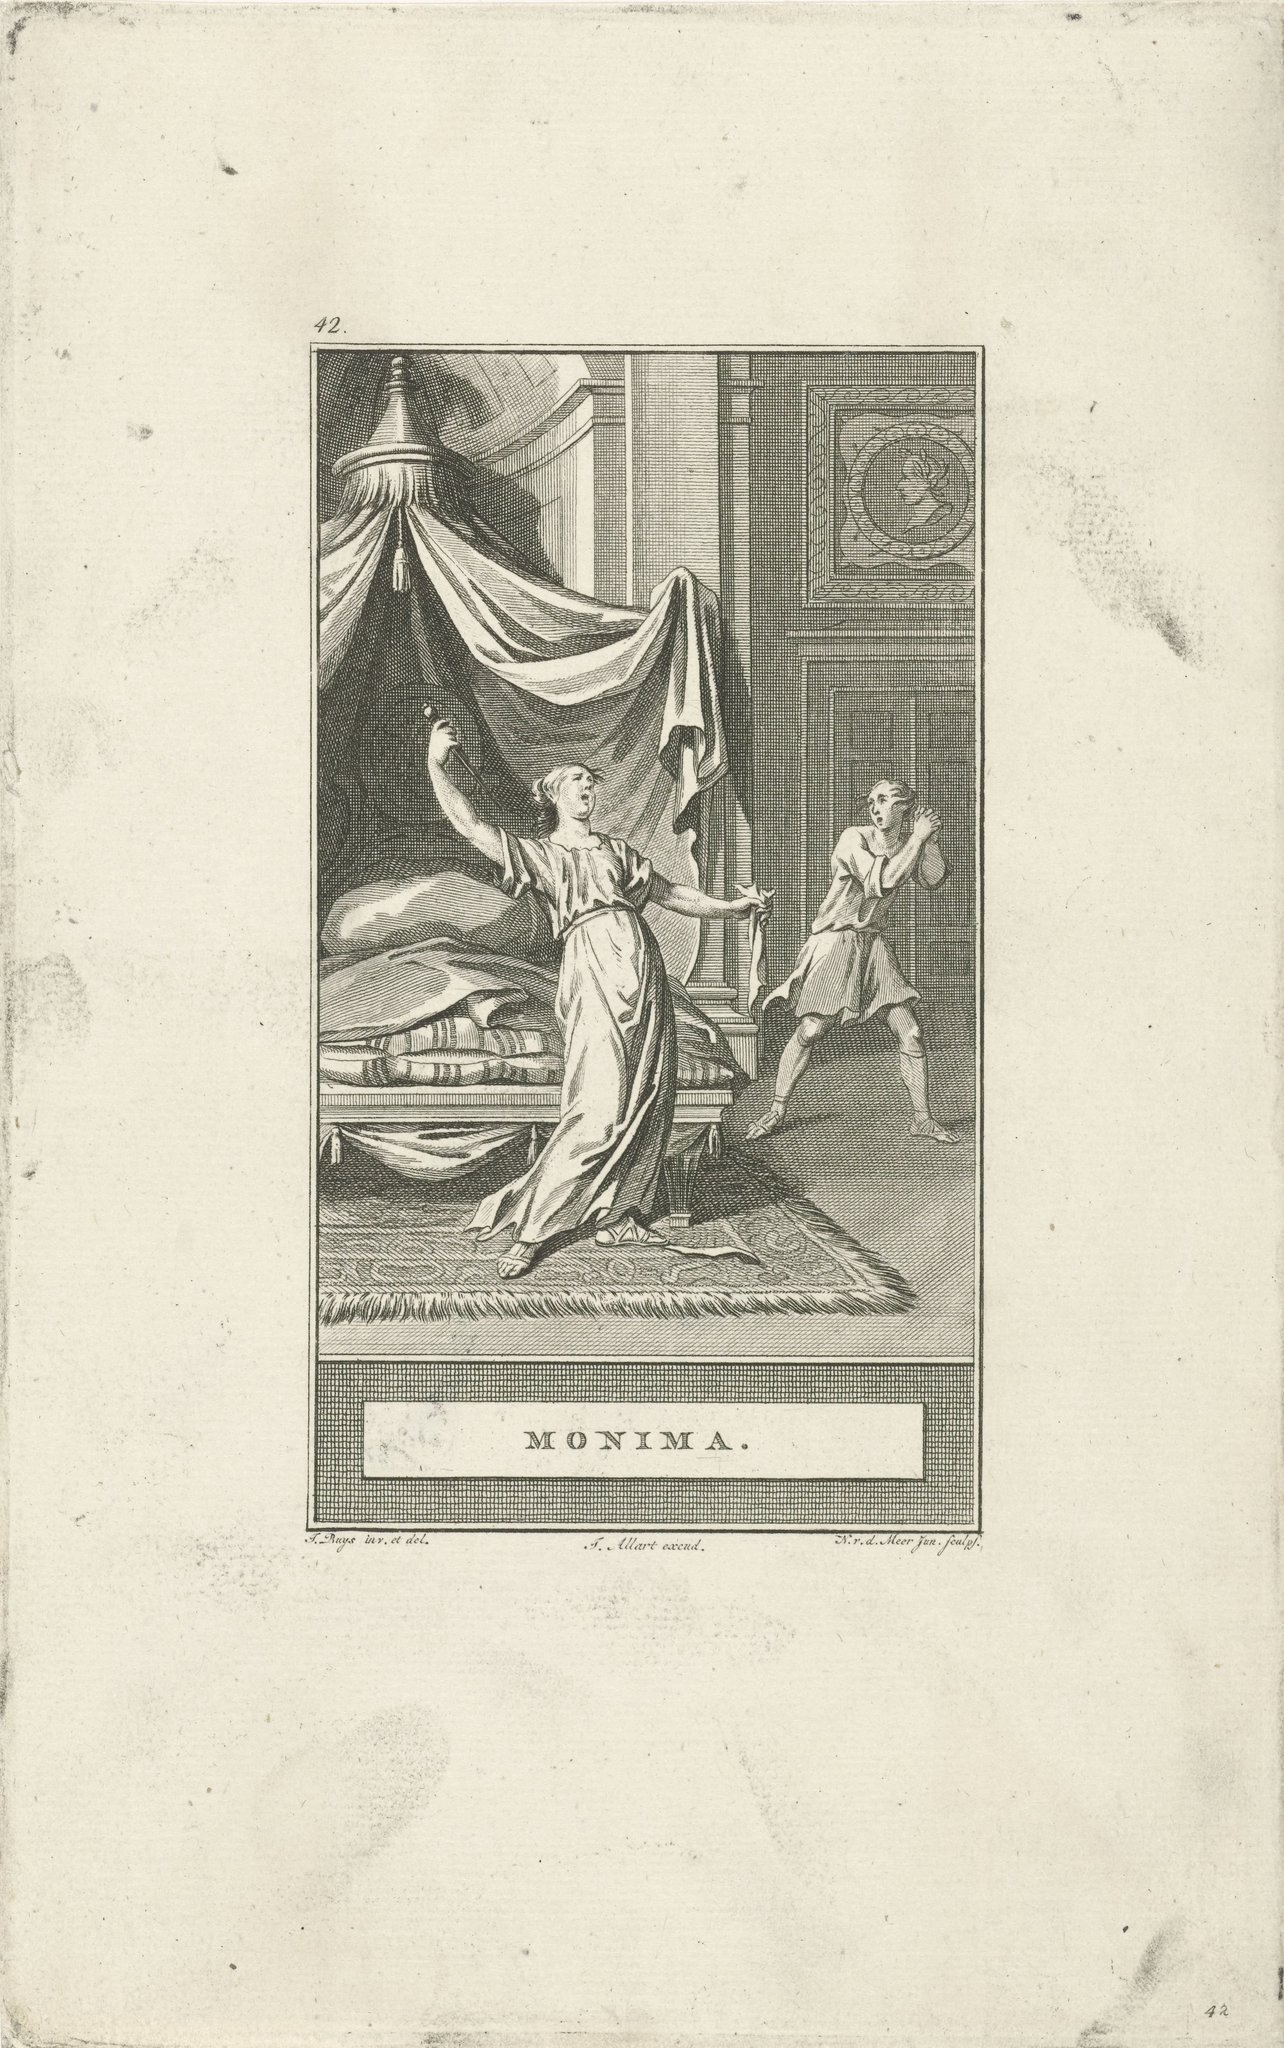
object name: book illustration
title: Monima's zelfmoord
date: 1778-1785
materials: paper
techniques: etching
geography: amsterdam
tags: seeking death, suicide, bedroom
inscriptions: collector's mark: Lugt 2228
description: Prent bij: Gellert, Christian Fürchtegott. Fabelen en vertelsels. 3 dln. Amsterdam: Pieter Meyer, 1772-1774. De prenten bij deze publicatie werden later uitgegeven. De exemplaren uitgegeven door de weduwe Jacobus Loveringh & Johannes Allart tussen 1777 en 1778, de exemplaren uitgegeven door alleen Johannes Allart tussen 1778 en 1785.